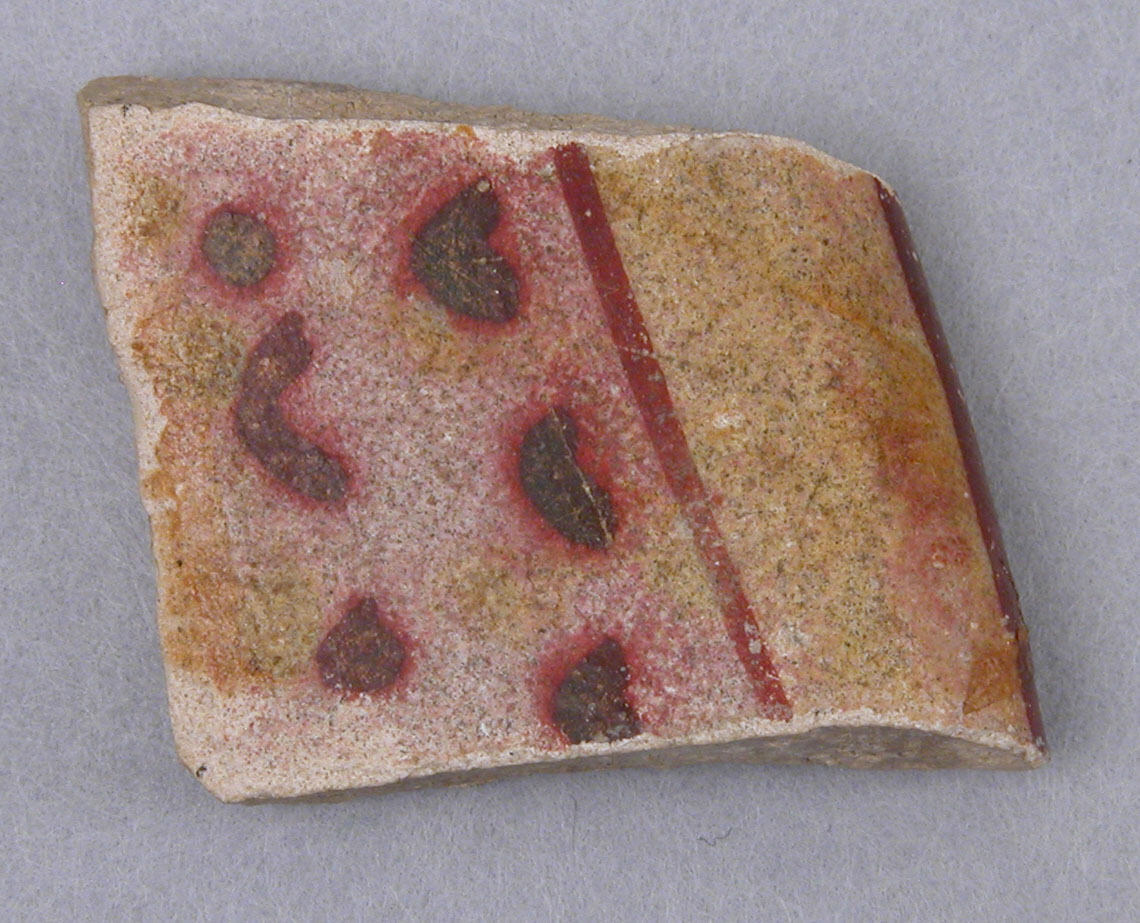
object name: fragment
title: Ceramic Fragment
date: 901-1100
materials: earthenware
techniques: luster painting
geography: saudi arabia